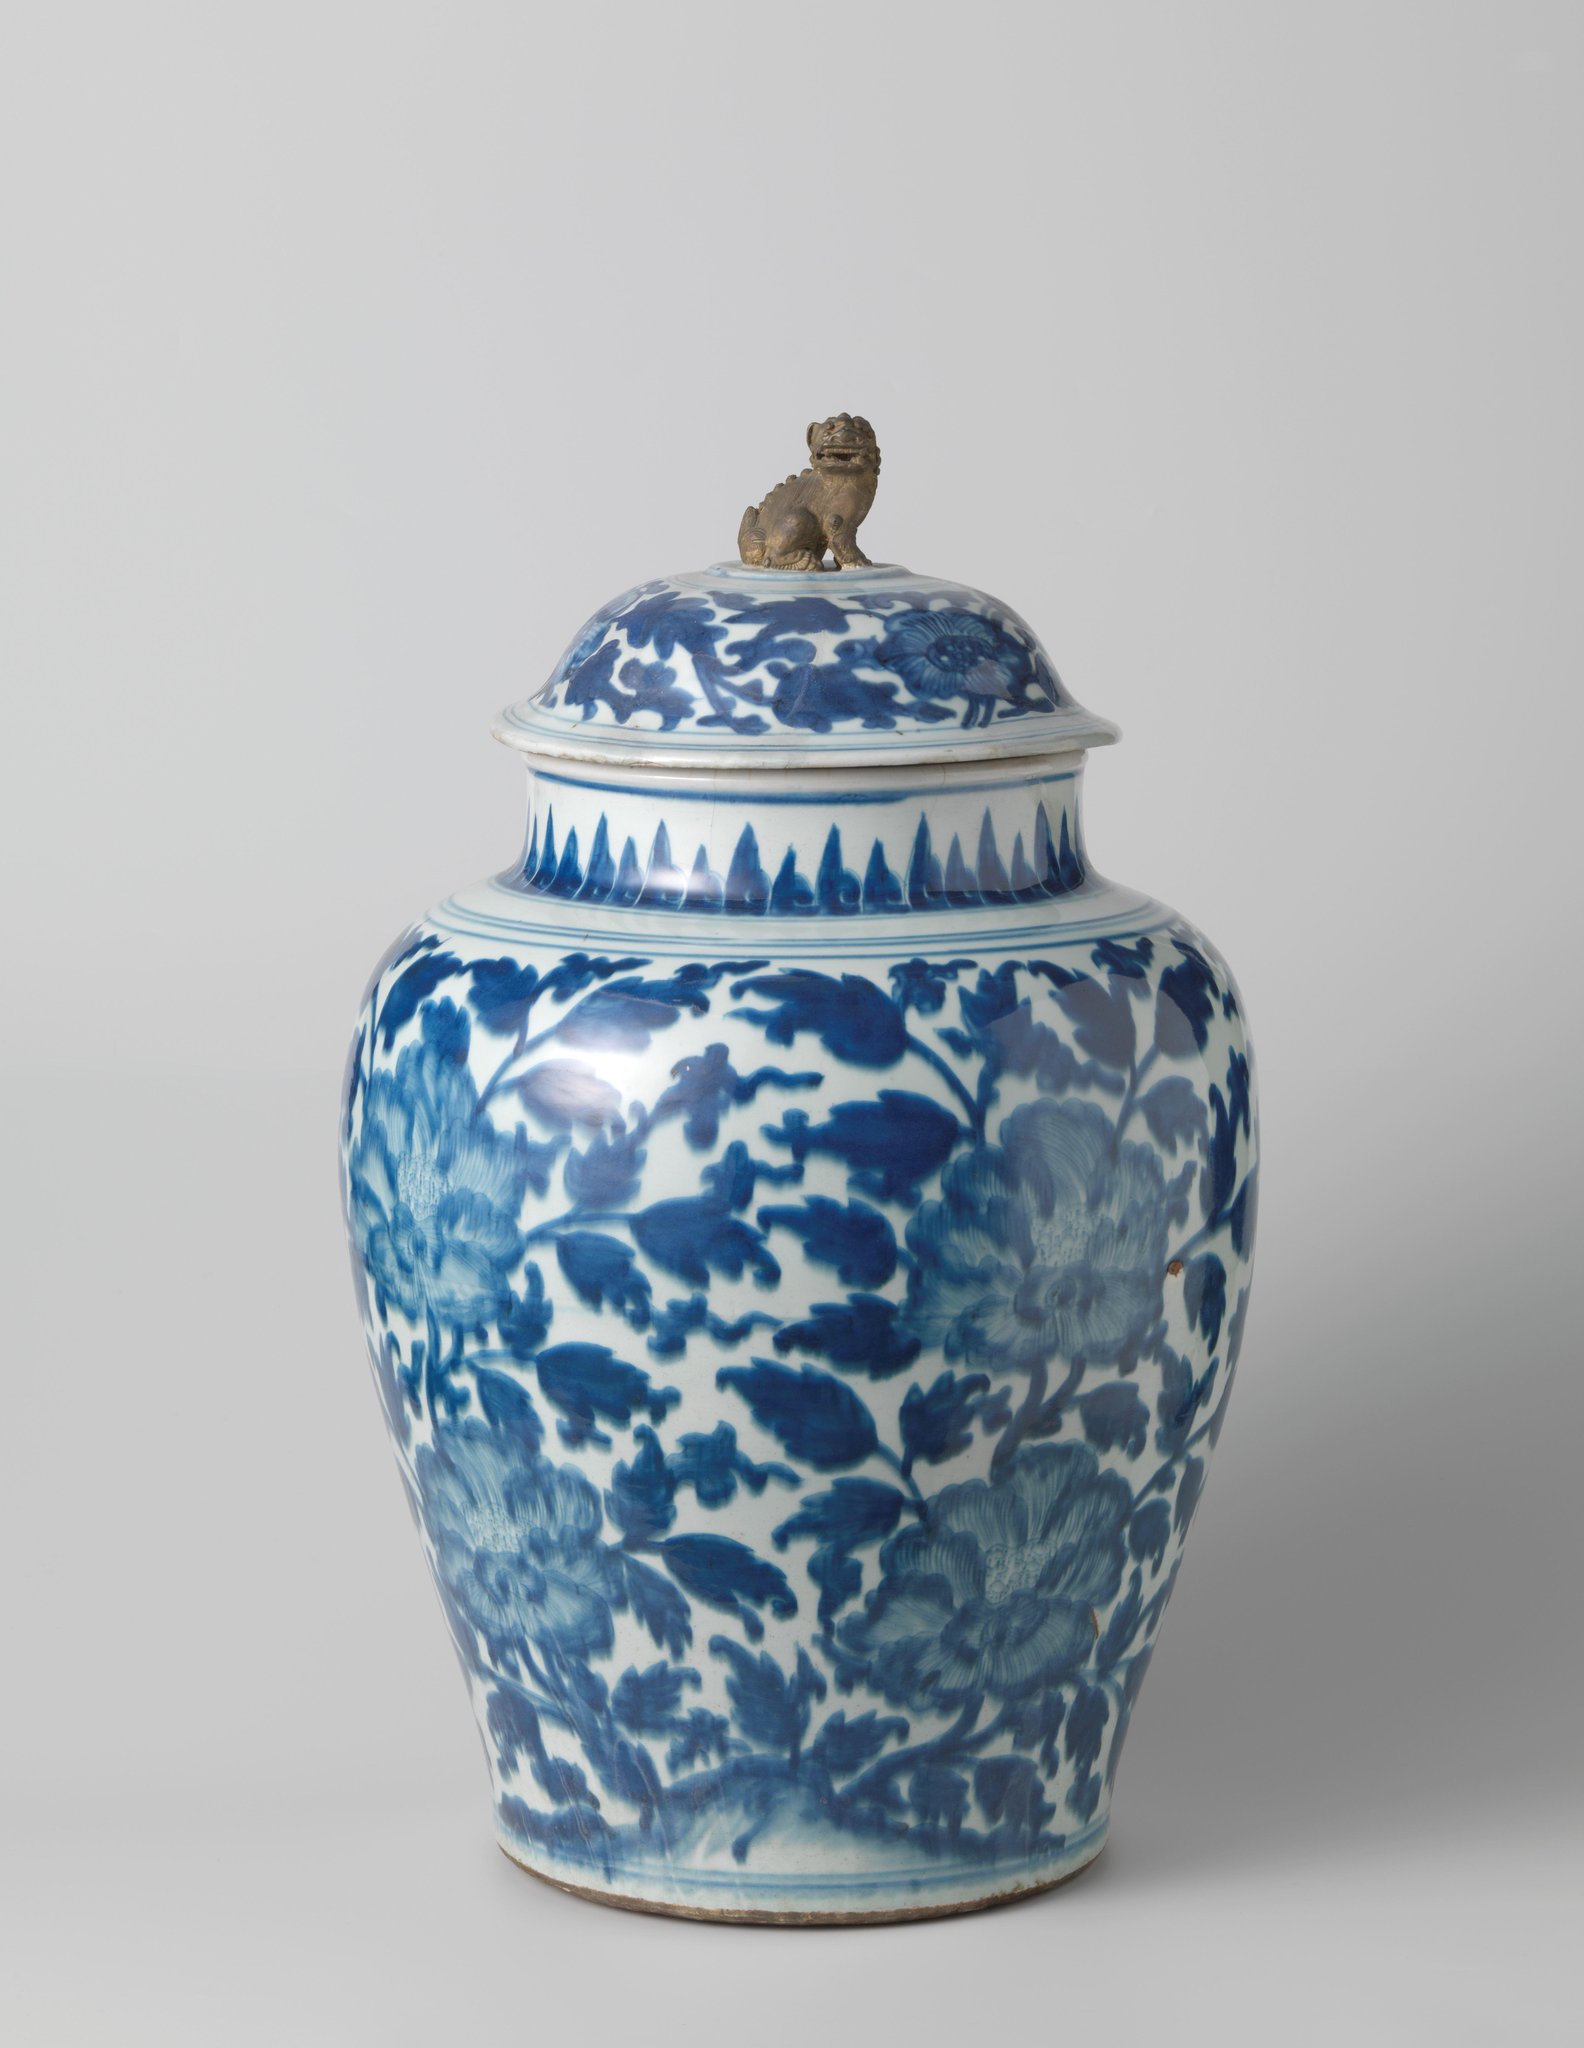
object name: lid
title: Ovoid covered jar with large peonies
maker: Anonymous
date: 1675-1699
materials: cobalt, glaze, gold, paint, porcelain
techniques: firing, forming, gilding, turning, vitrification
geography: china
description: Deksel van pot van porselein met een brede nek, beschilderd in onderglazuur blauw. Op de wand vier grote pioenen bij twee rotsen. Op de hals een band met puntige bladmotieven. Dekselknop in de vorm van een vergulde shishi (leeuwhond). Deksel is gebroken geweest. Blauw-wit.